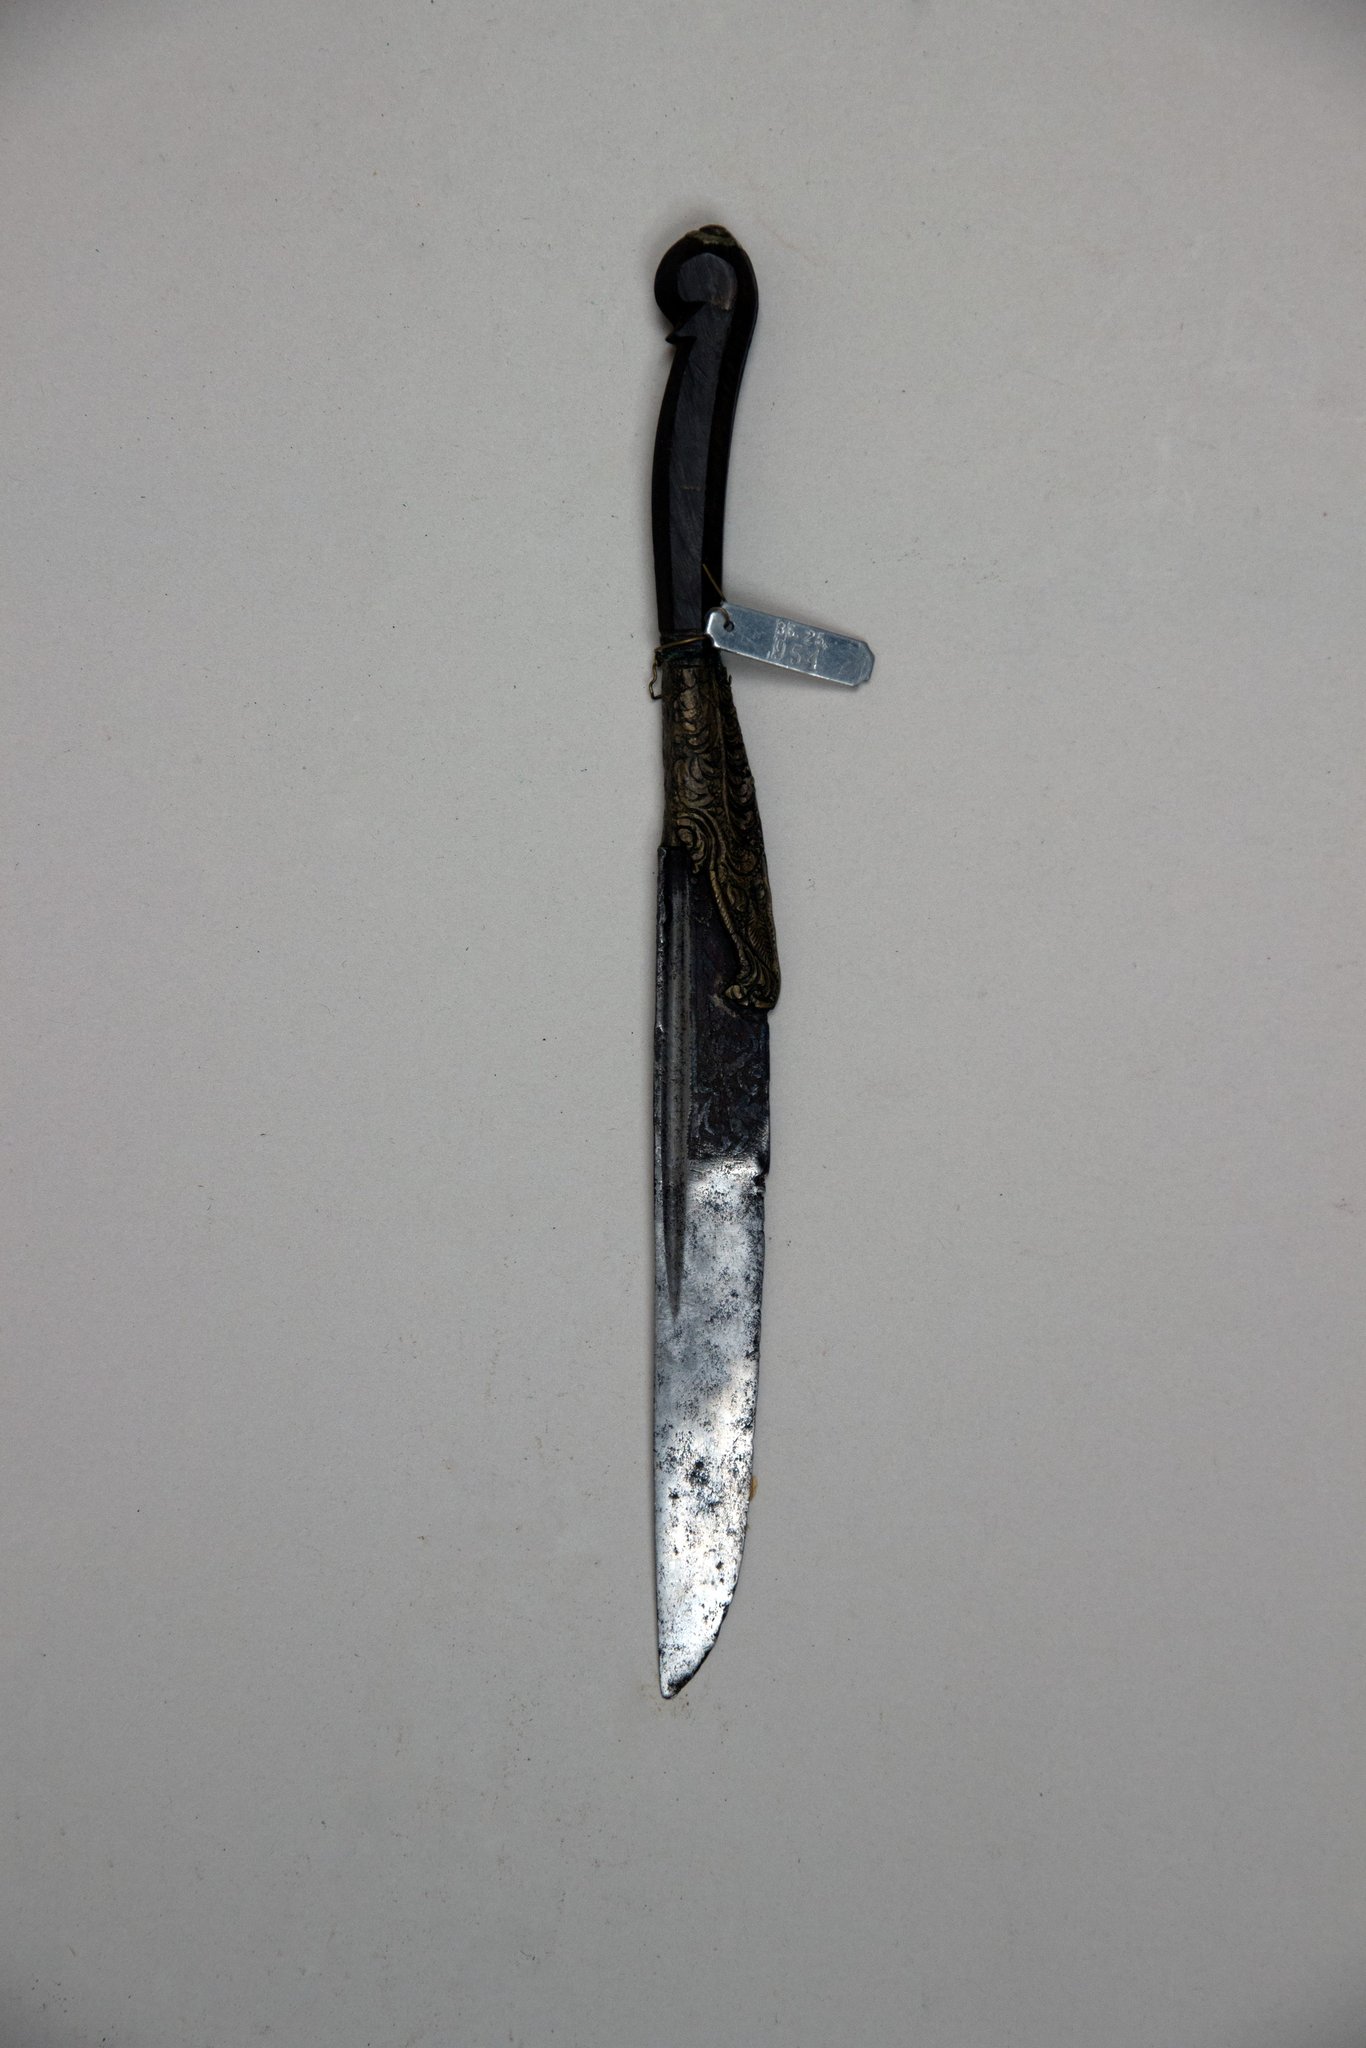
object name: knife piha kaetta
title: Knife (Phia Kaetta)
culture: sri lankan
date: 1701-1900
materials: brass, steel, wood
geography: sri lanka